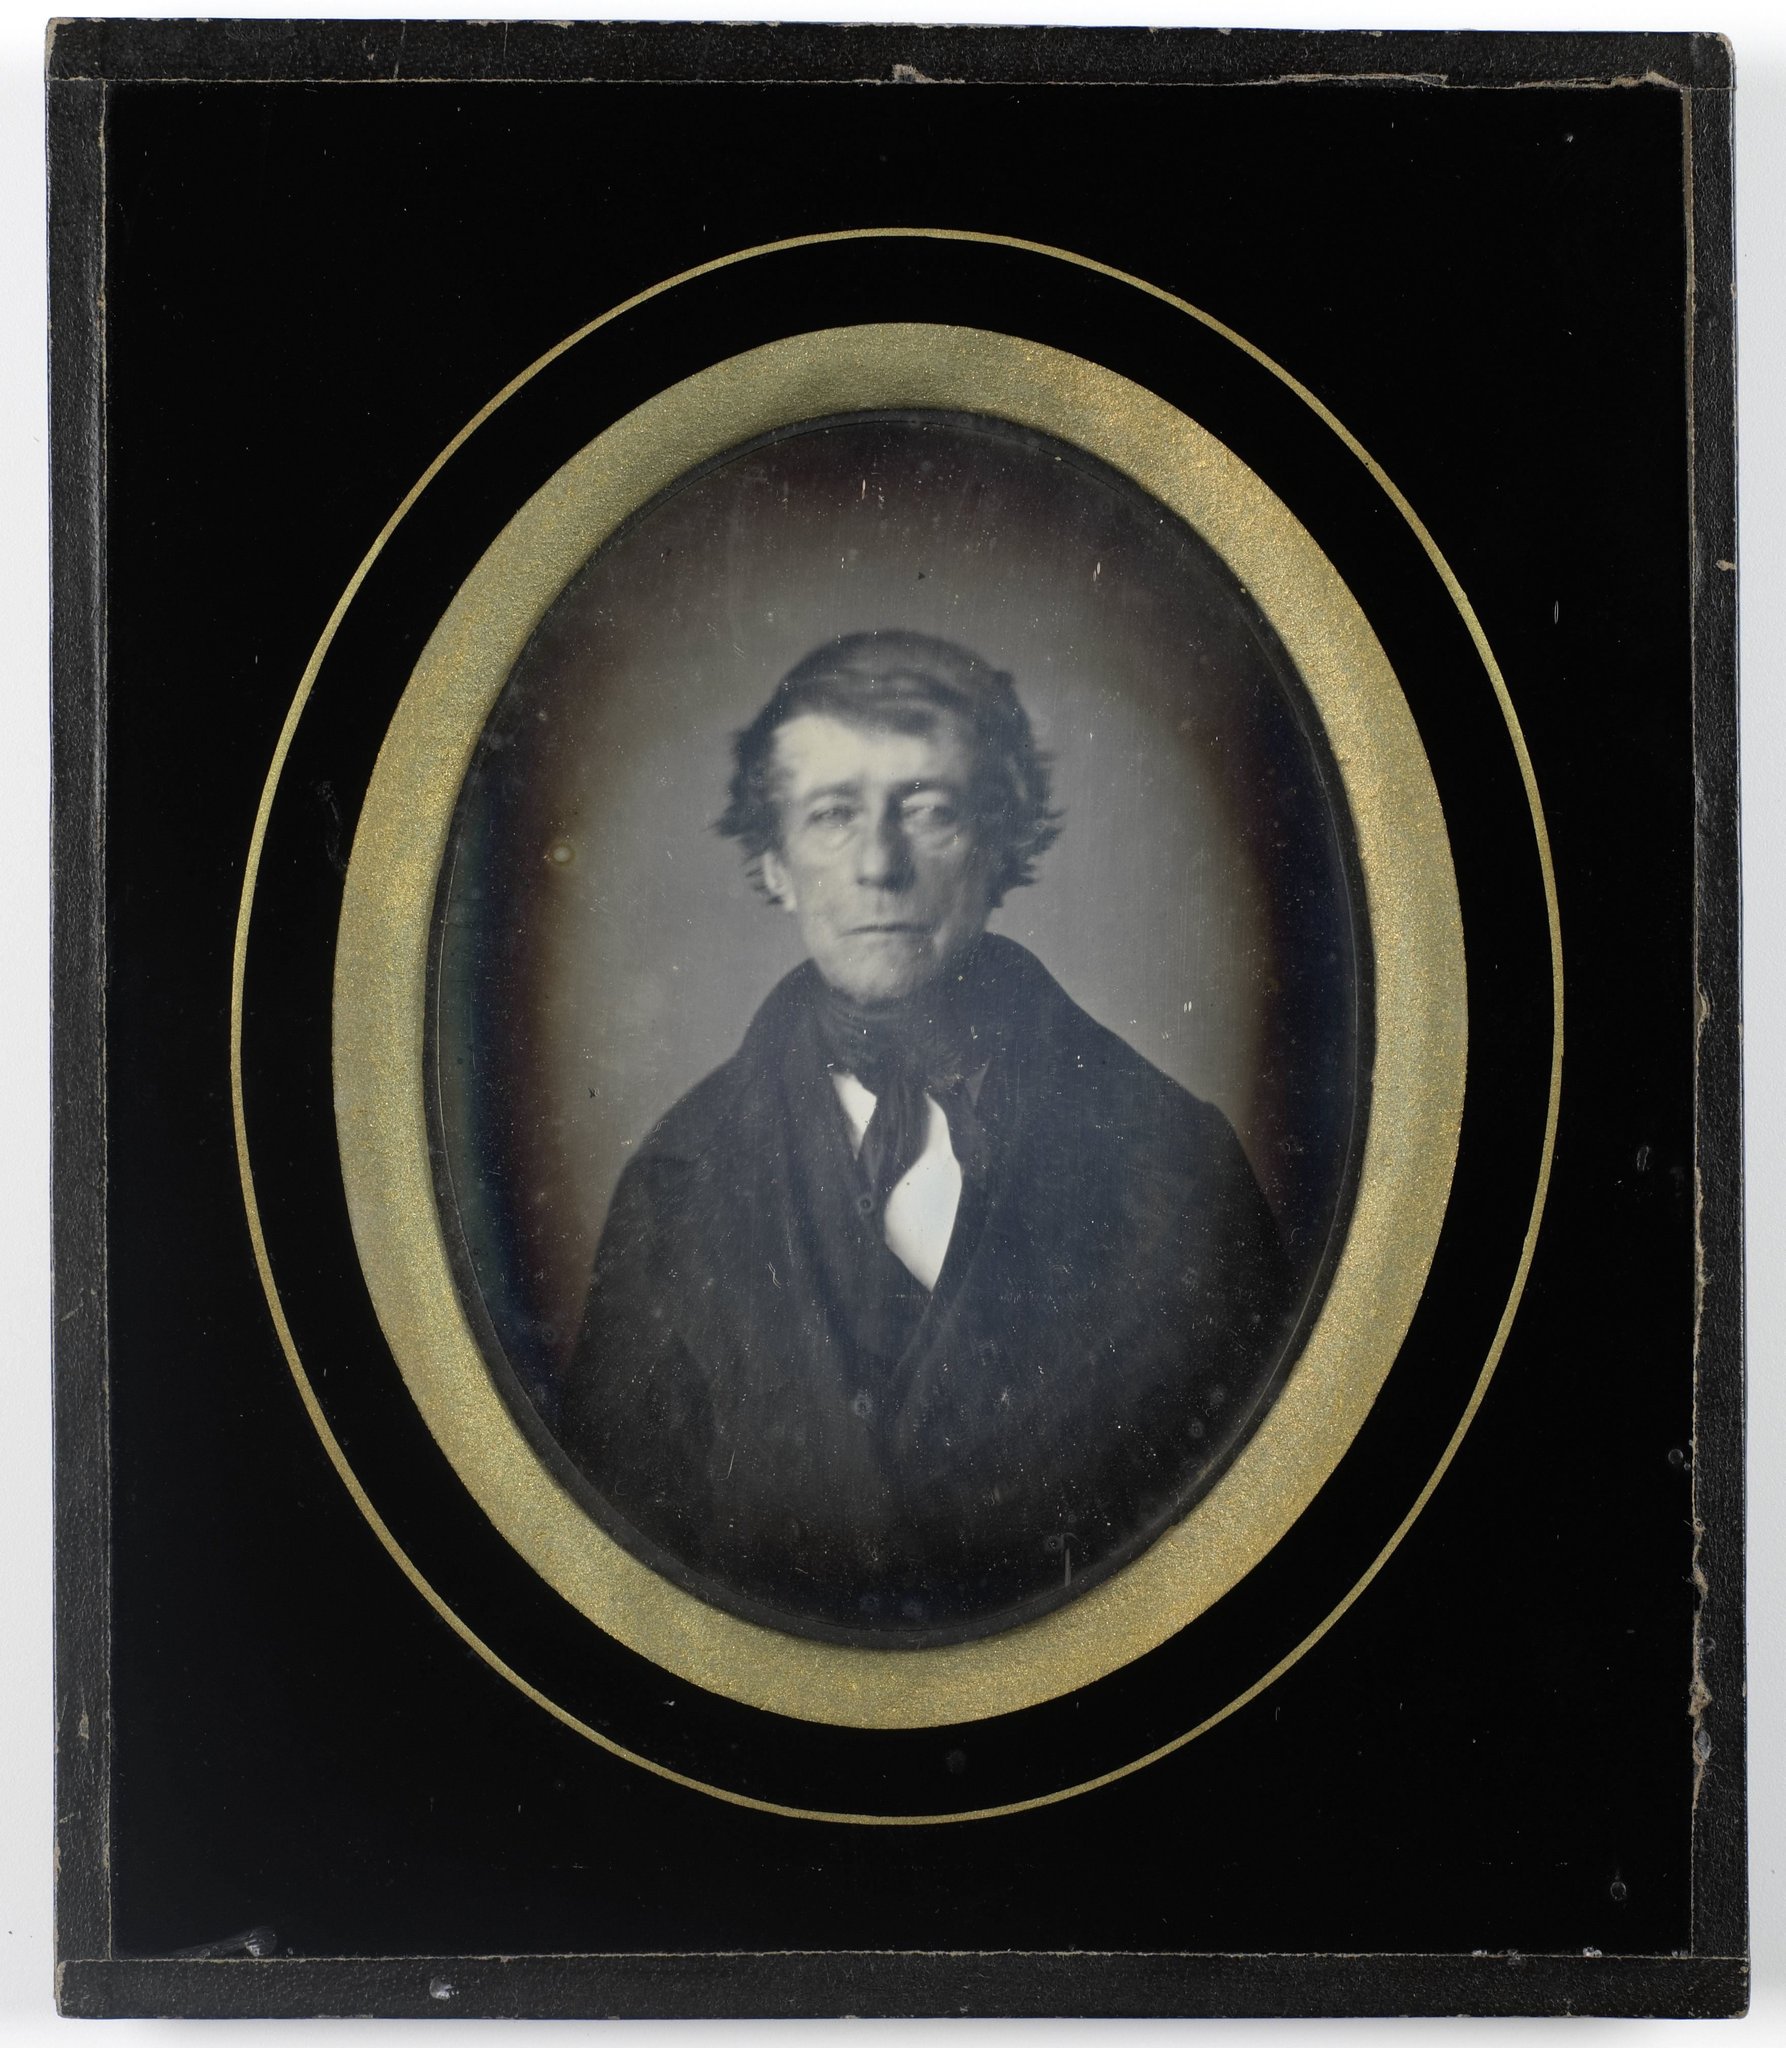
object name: photograph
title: Portret van een onbekende man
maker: hendrik hermanus roelse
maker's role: fotograaf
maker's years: 1831-1872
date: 1840-1860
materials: copper, glass, paper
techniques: daguerreotype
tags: adult man, historical persons